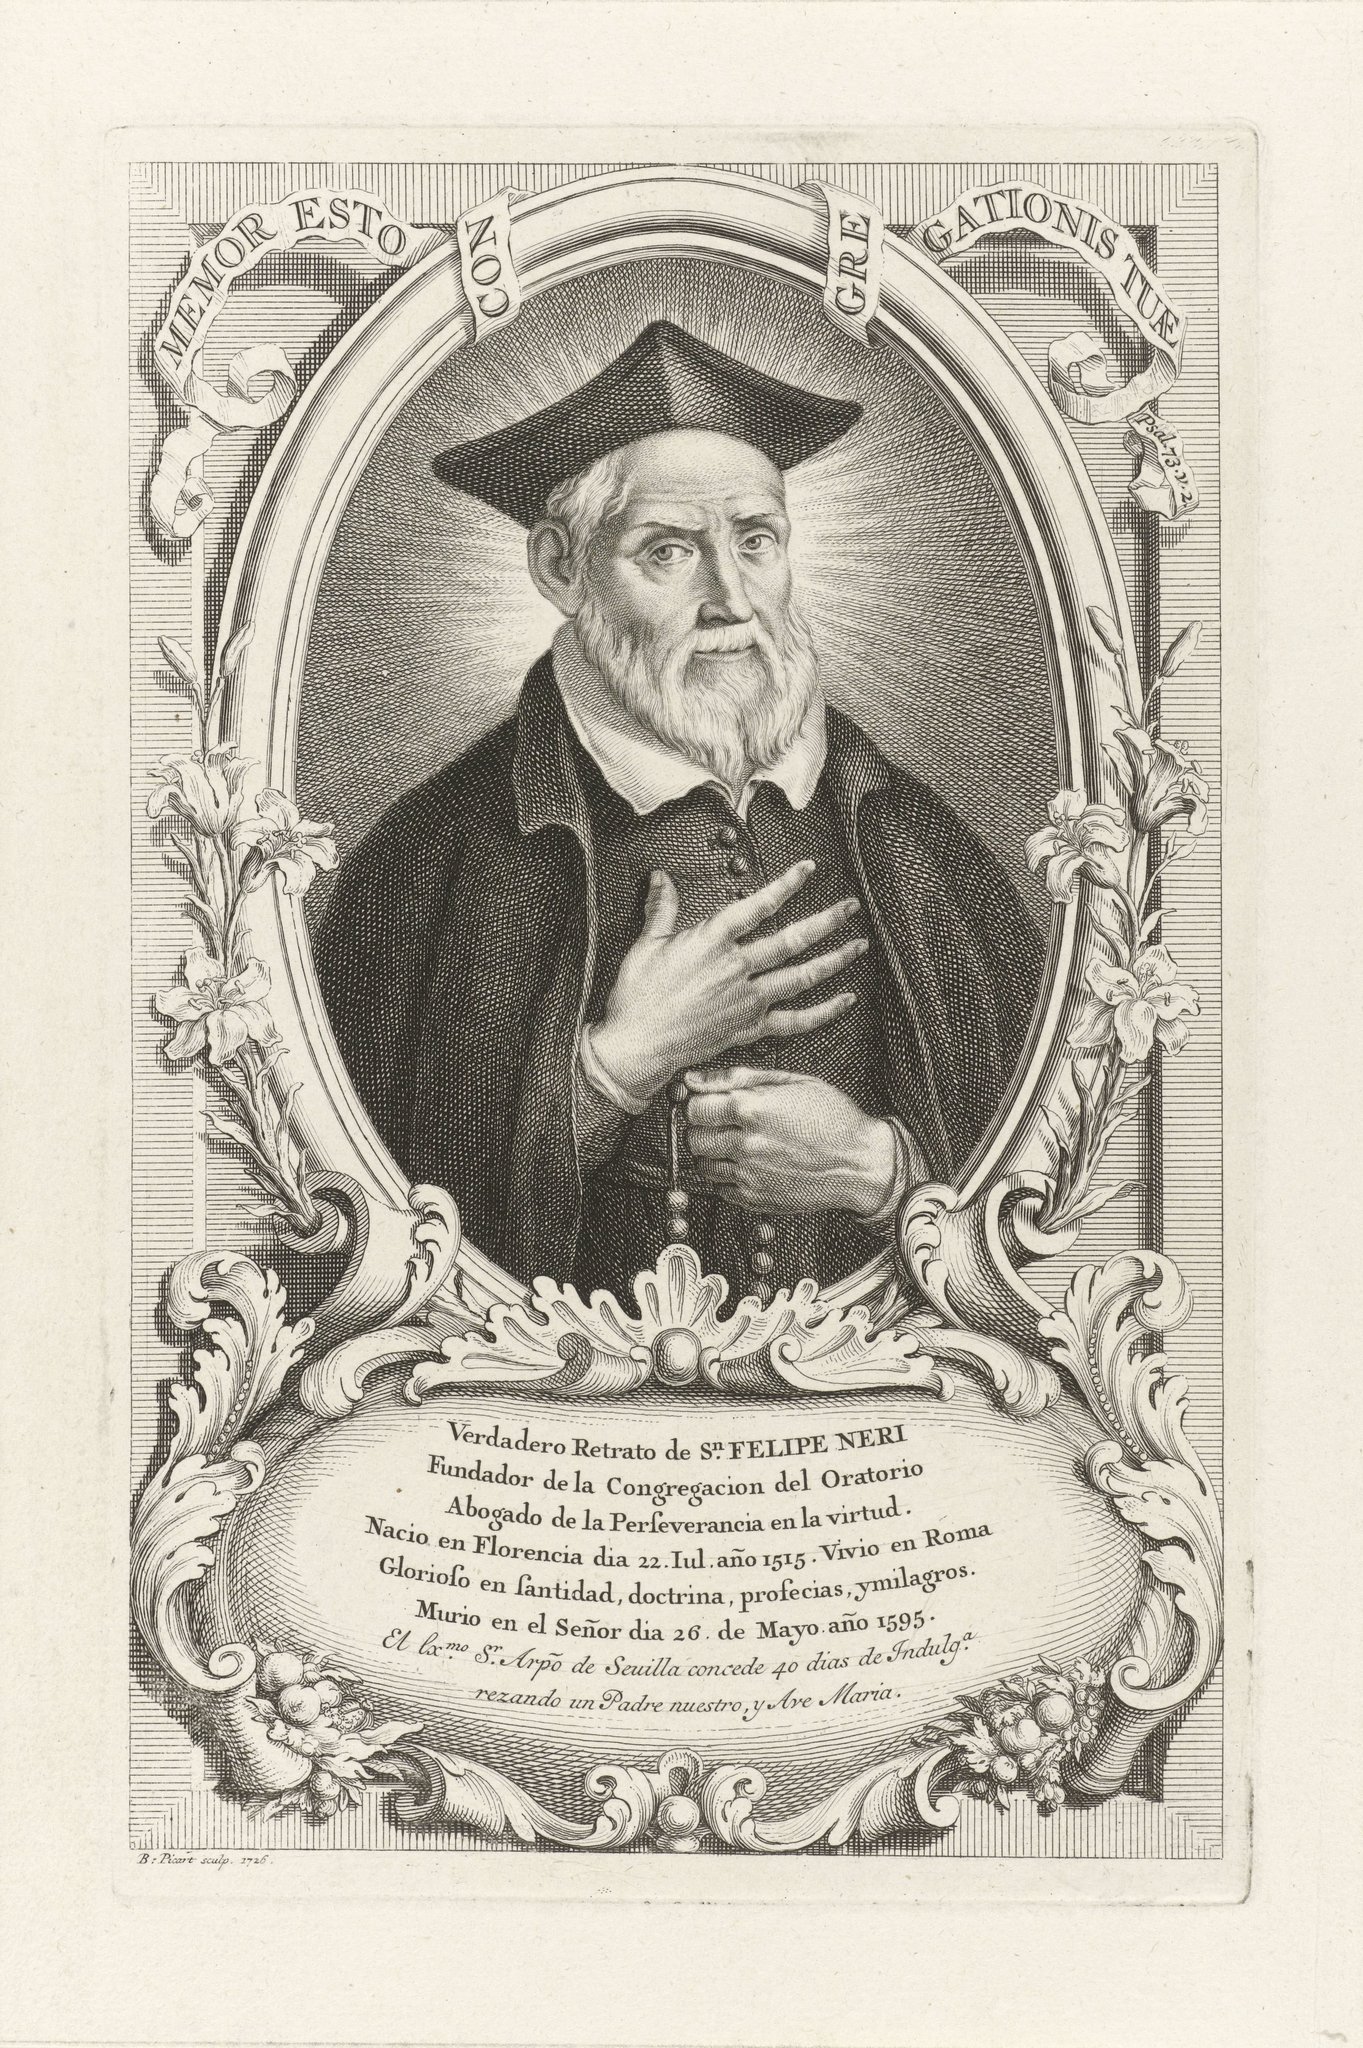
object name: print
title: Portret van de heilige Filippo Neri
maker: bernard picart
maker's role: draughtsman, print maker, publisher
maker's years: 1673-1733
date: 1726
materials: paper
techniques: engraving, etching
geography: amsterdam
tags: rome, clergyman, floral interlace ~ ornament, saying the rosary, the founder of the congregation of the oratory (oratorians) philip neri; possible attributes: lily, rosary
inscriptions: collector's mark: Lugt 240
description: Portret van de H. Filippo Neri. Hij bidt de rozenkrans. Zijn portret is gevat in een ovale omlijsting die is gedecoreerd met bloemen en wordt bekroond door een banderol waarop een Bijbelcitaat uit Ps. 73:2 in het Latijn. In de cartouche een achtregelig onderschrift in het Spaans.